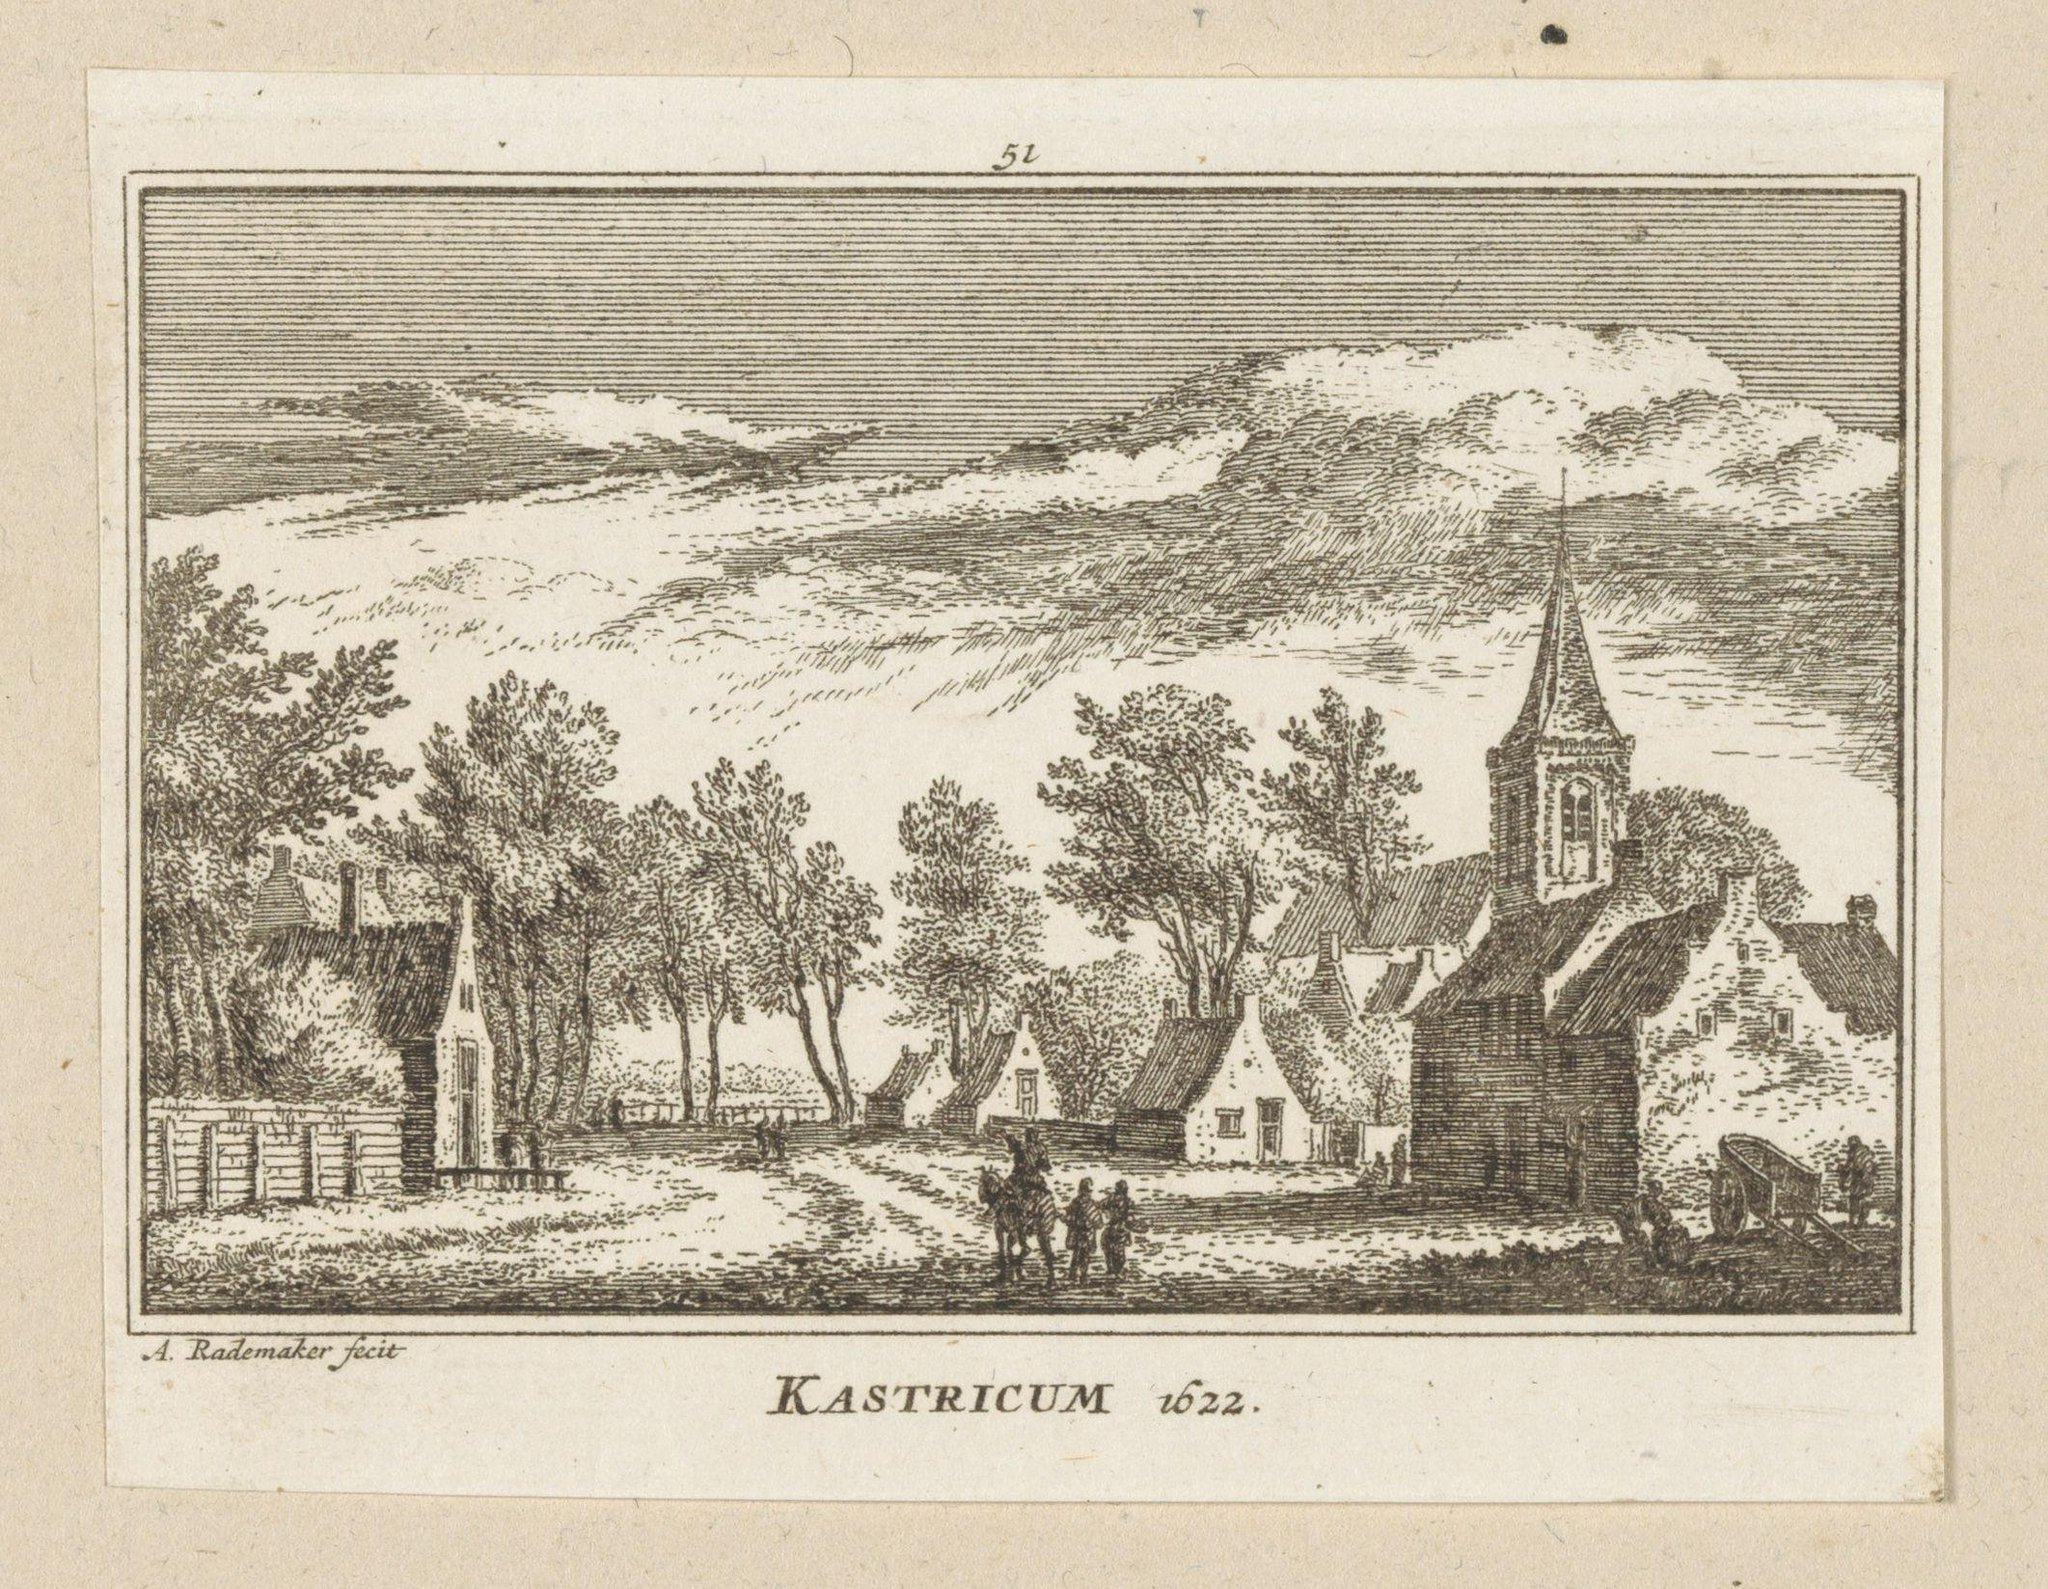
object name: print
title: Kastricum 1622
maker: abraham rademaker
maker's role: draughtsman, print maker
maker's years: 1676-1735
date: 1725-1803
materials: paper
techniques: engraving, etching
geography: amsterdam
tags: prospect of village, silhouette of village, church (exterior)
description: Prent ook gebruikt in: Rademaker, Abraham. Kabinet van Nederlandsche outheden en gezichten: vervat in 300 konstplaaten (…). 2 delen. Amsterdam: Willem Barents, 1725, dl. 1, ill. 51. Na 1725 is deze prent nog in verschillende heruitgaven verschenen, uitgegeven in 1727-1733, 1770-1771 en 1792-1803. Uit welke uitgave het huidige exemplaar precies komt is niet na te gaan.